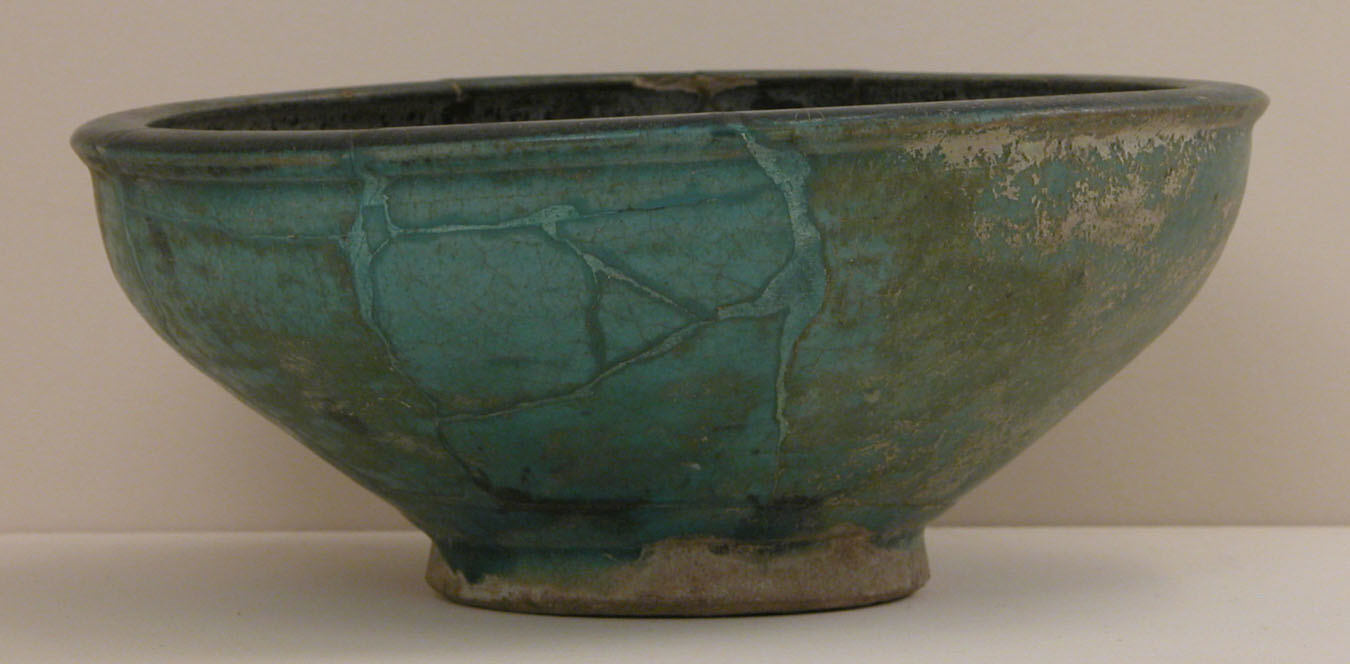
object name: bowl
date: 1201-1300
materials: stonepaste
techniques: glazing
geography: iran